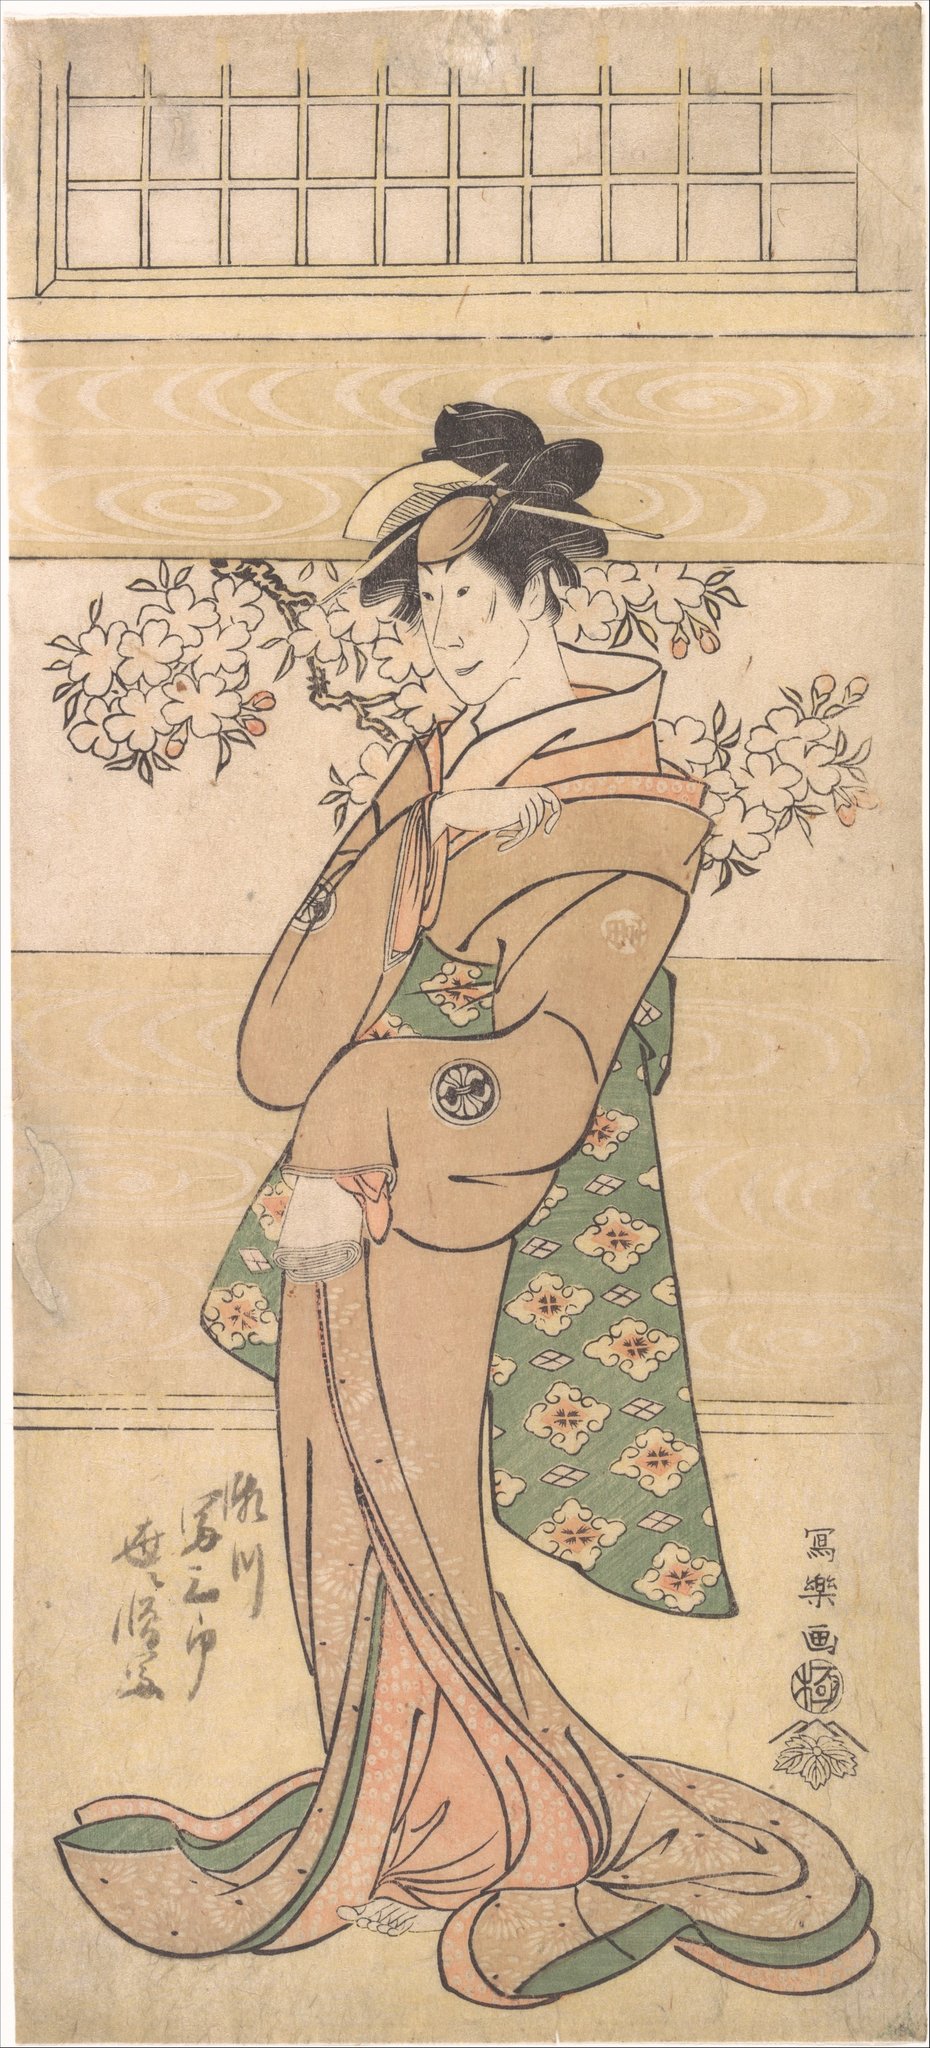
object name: print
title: Actor Segawa Tomisaburo II as the Geisha Asaka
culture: japanese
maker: tōshūsai sharaku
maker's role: artist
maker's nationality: japanese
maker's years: 1794-1795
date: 1794-1795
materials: ink, paper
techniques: woodblock print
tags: men,women,actors